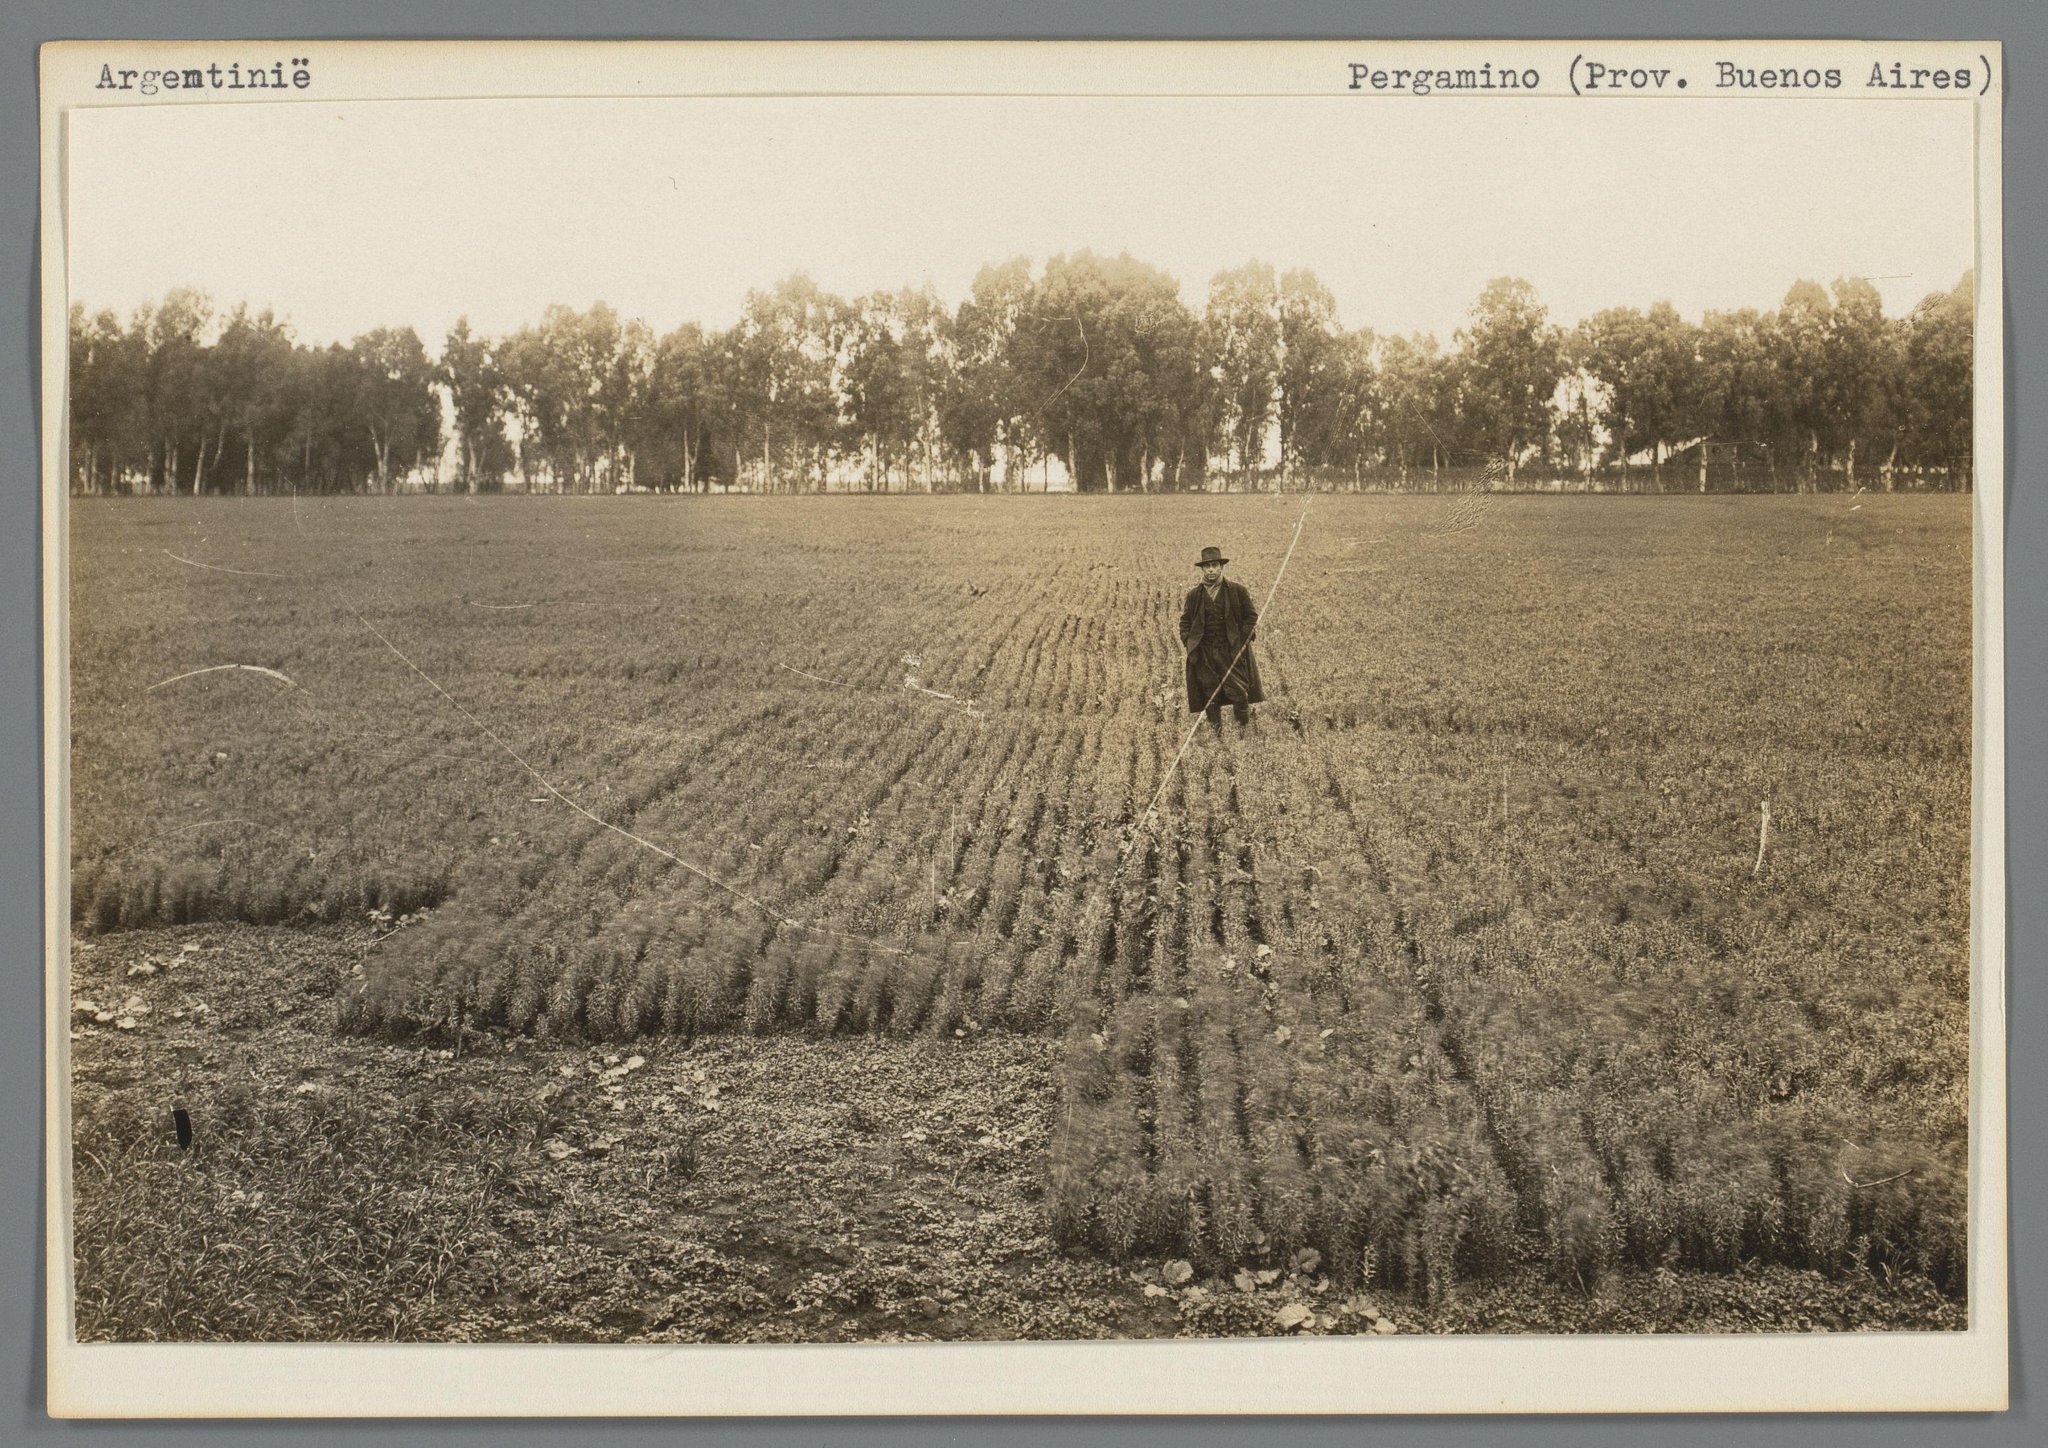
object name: photograph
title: Argentinië. Pergamino (Prov. Buenos Aires)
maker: Anonymous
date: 1900-1930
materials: paper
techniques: gelatin silver print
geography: pergamino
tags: flax (material ~ textile industry), field filled with a crop (+ landscape with figures, staffage)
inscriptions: number: ‘40.908’, stamp: ‘REPÚBLICA ARGENTINA/ MINISTERIO D'AGRICULTURA DE LA MACIOR/ [...]/ DIVISION FOTO-CINEMATOGRAFIA’, inscription: ‘Proeftuin voor linnen’, number: ‘970000’, inscription: ‘Chacra Experimental del Mnisterio de Agricultura en Pergamino. Prov. de Buen/ Aires./ Cultivo de lino. (1)/ Champ expérimental à Pergamino (Province de Buenos Aires) appartenant au Minis/tère de l'Agriculture. La culture du Lin.-’